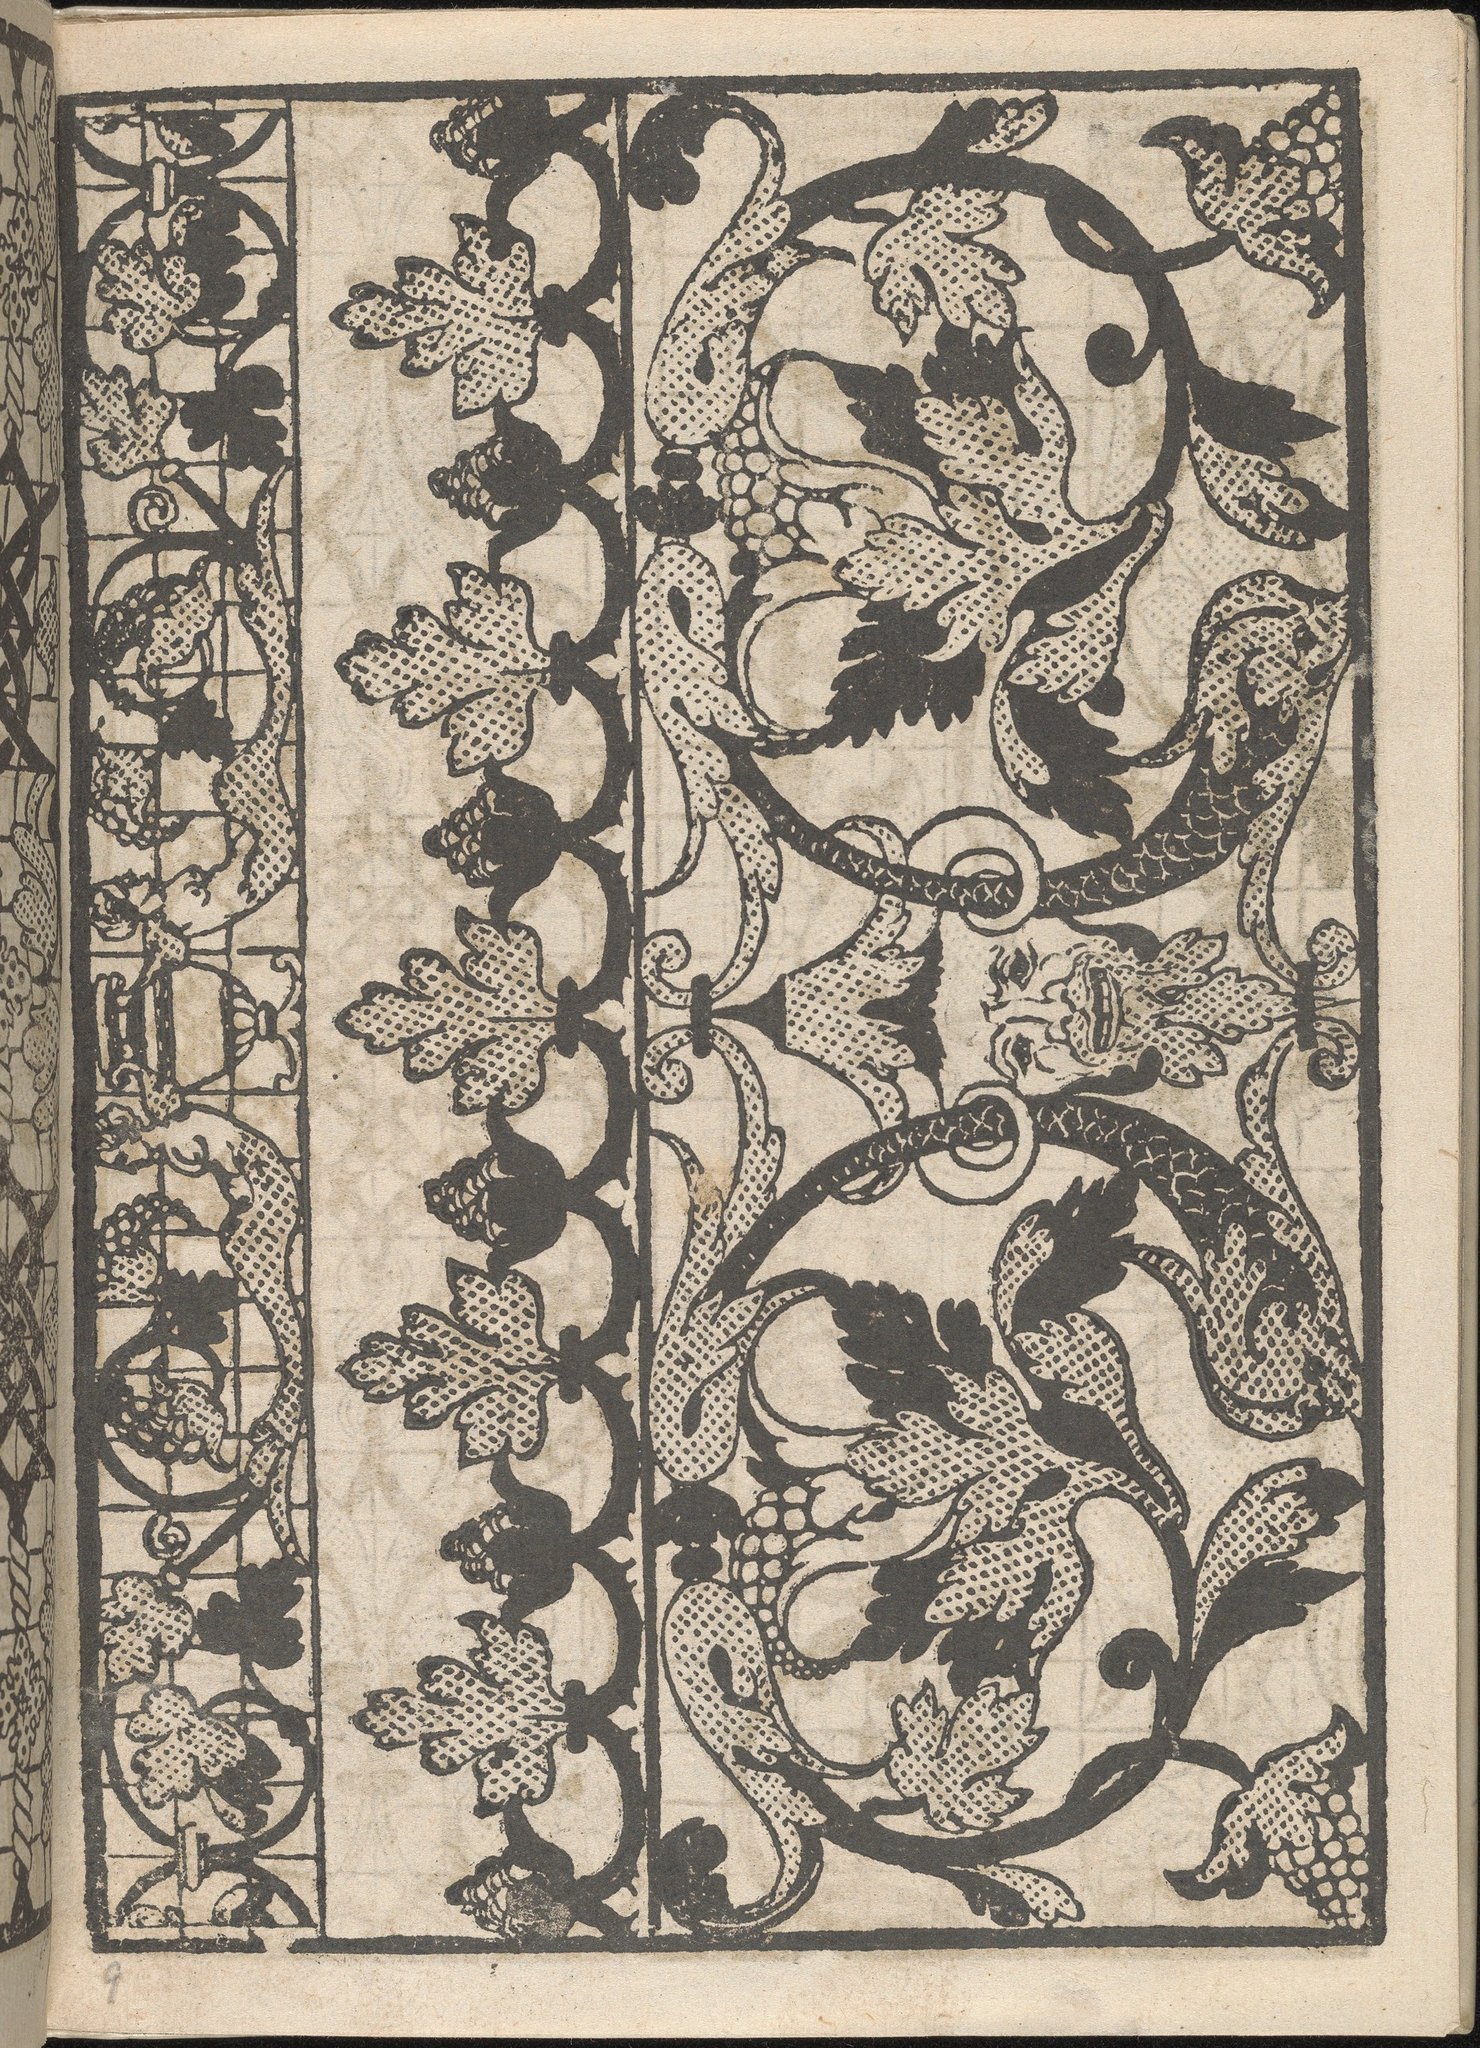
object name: book print ornament architecture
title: Splendore delle virtuose giovani, page 5 (recto)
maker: iseppo foresto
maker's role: designer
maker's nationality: italian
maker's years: 1520-1580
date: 1564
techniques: woodcut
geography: italy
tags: flowers